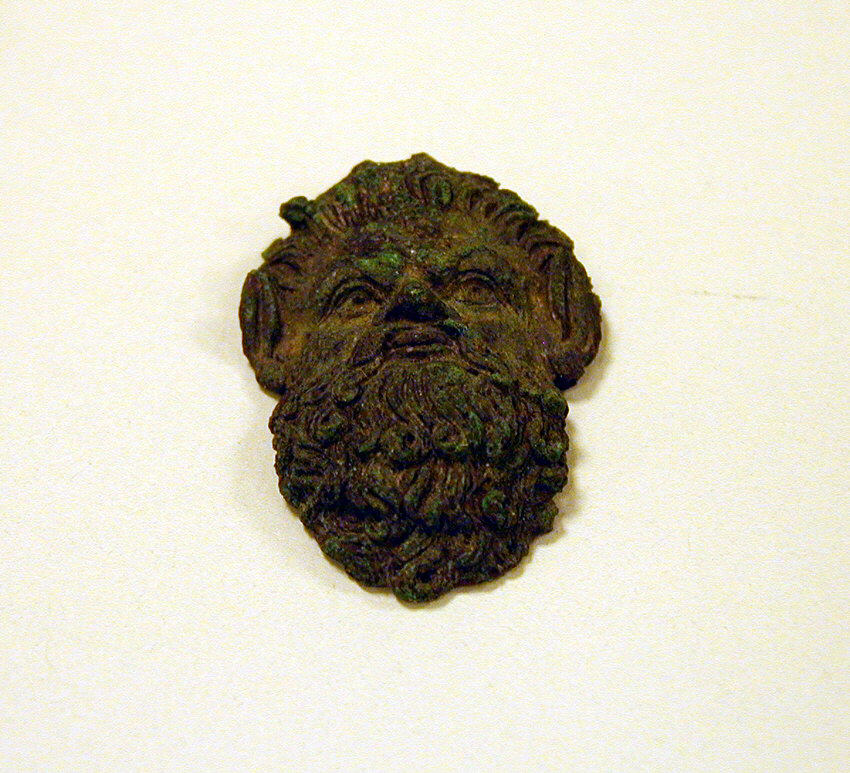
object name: handle attachment, mask of a satyr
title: Bronze handle attachment in the form of a satyr mask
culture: greek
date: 200-101 BCE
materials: bronze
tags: masks,satyrs